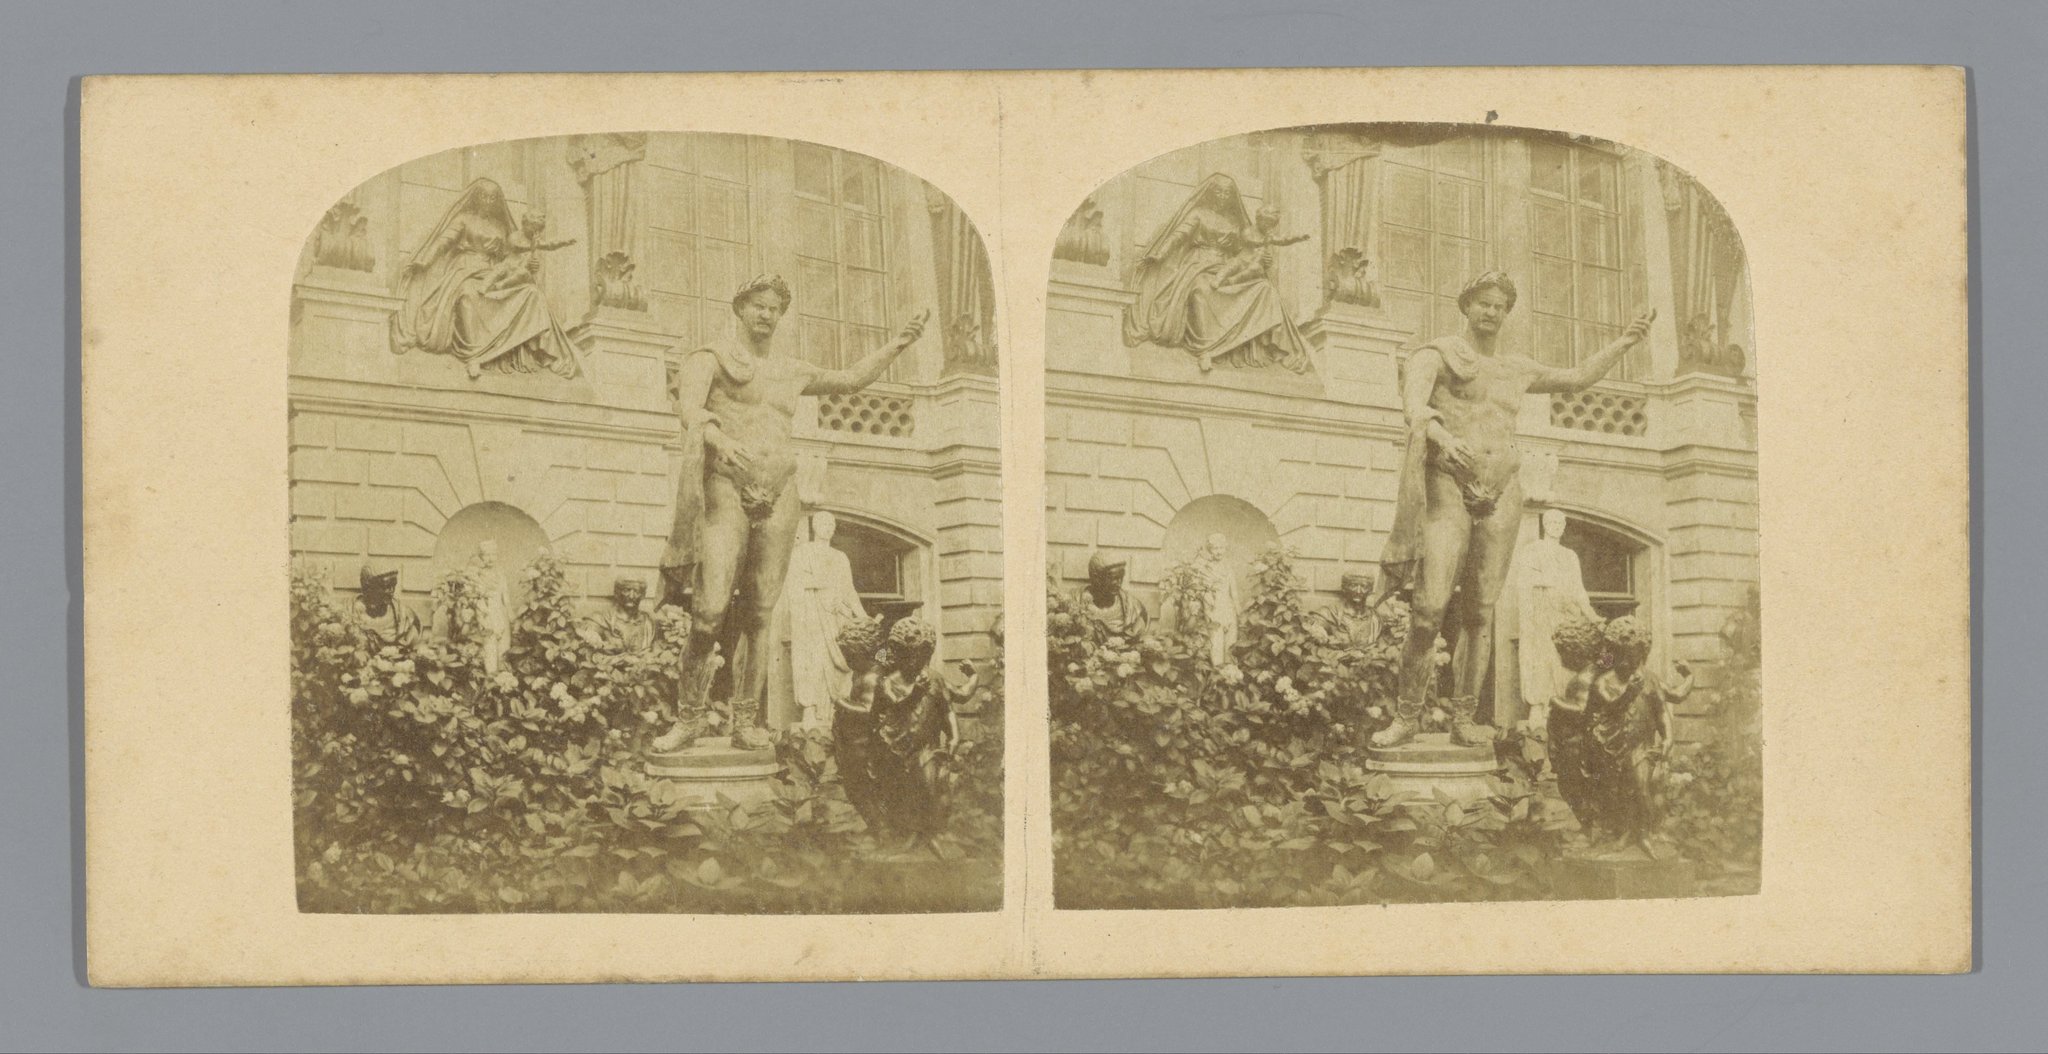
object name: stereograph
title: Sculptuur van Alexander de Grote bij het huis van Auguste de Montferrand in Sint-Petersburg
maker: Anonymous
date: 1850-1880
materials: cardboard, photographic support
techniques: albumen print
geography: sint-petersburg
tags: piece of sculpture, reproduction of a piece of sculpture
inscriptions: inscription: ‘67 Alexandre le grand chez Mr. de Montferrand St. Pétersbourg’